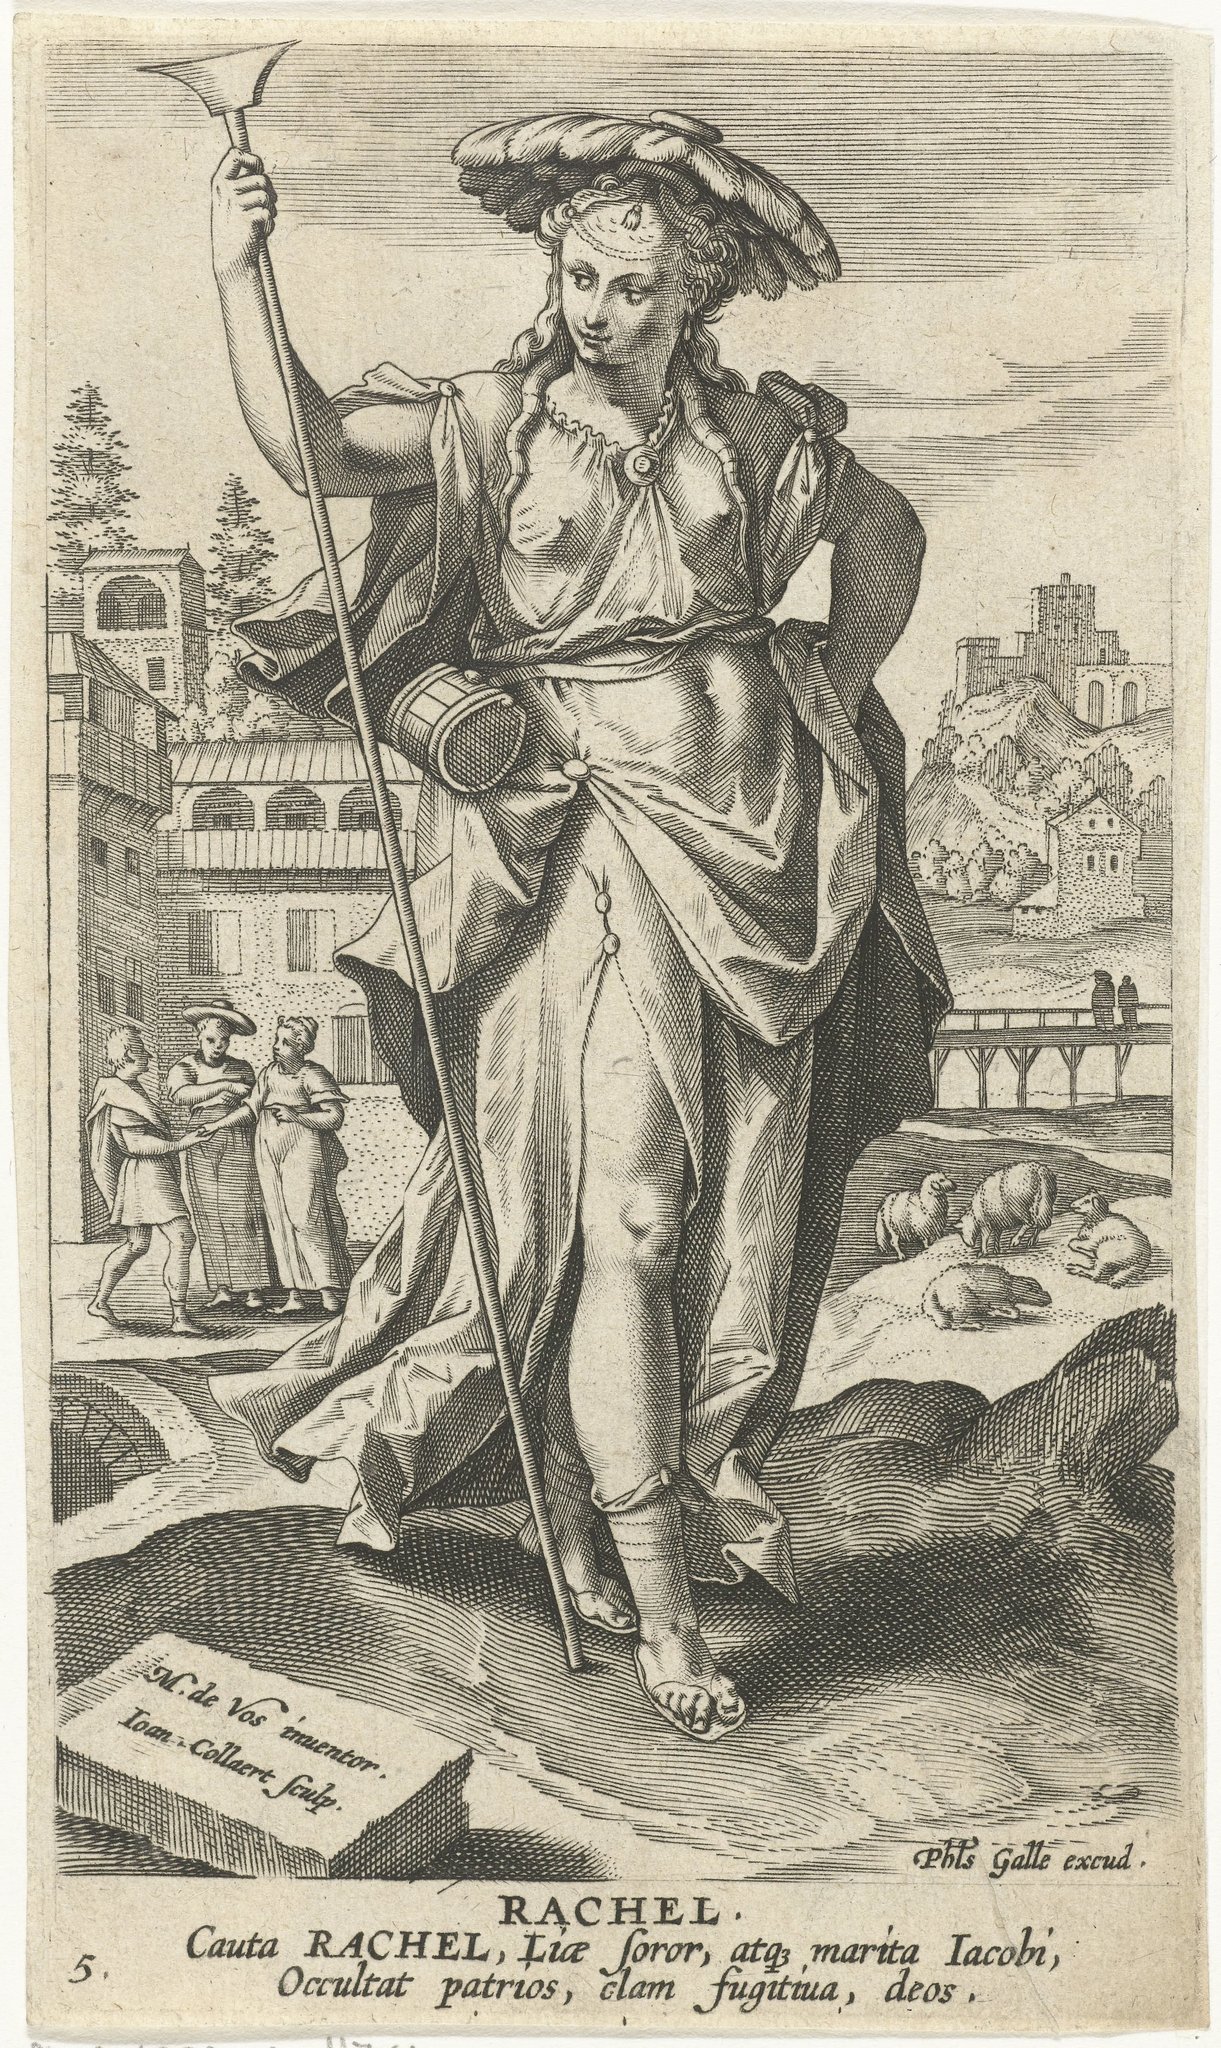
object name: print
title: Icones Illvstrivm Feminarvm Veteris Testamenti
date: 1588-1597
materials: paper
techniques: engraving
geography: antwerp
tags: jacob sees rachel coming to the well to water laban's sheep, rachel (not in biblical context)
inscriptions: collector's mark: Lugt 2228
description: Op de voorgrond Rachel. de tweede vrouw van Jacob. Op de achtergrond wordt Jacob voorgesteld aan de dienstmeid van Rachel, met wie hij een kind moet verwekken. De prent heeft een Latijns onderschrift en maakt deel uit van een prentserie met beroemde vrouwen uit het Oude Testament.